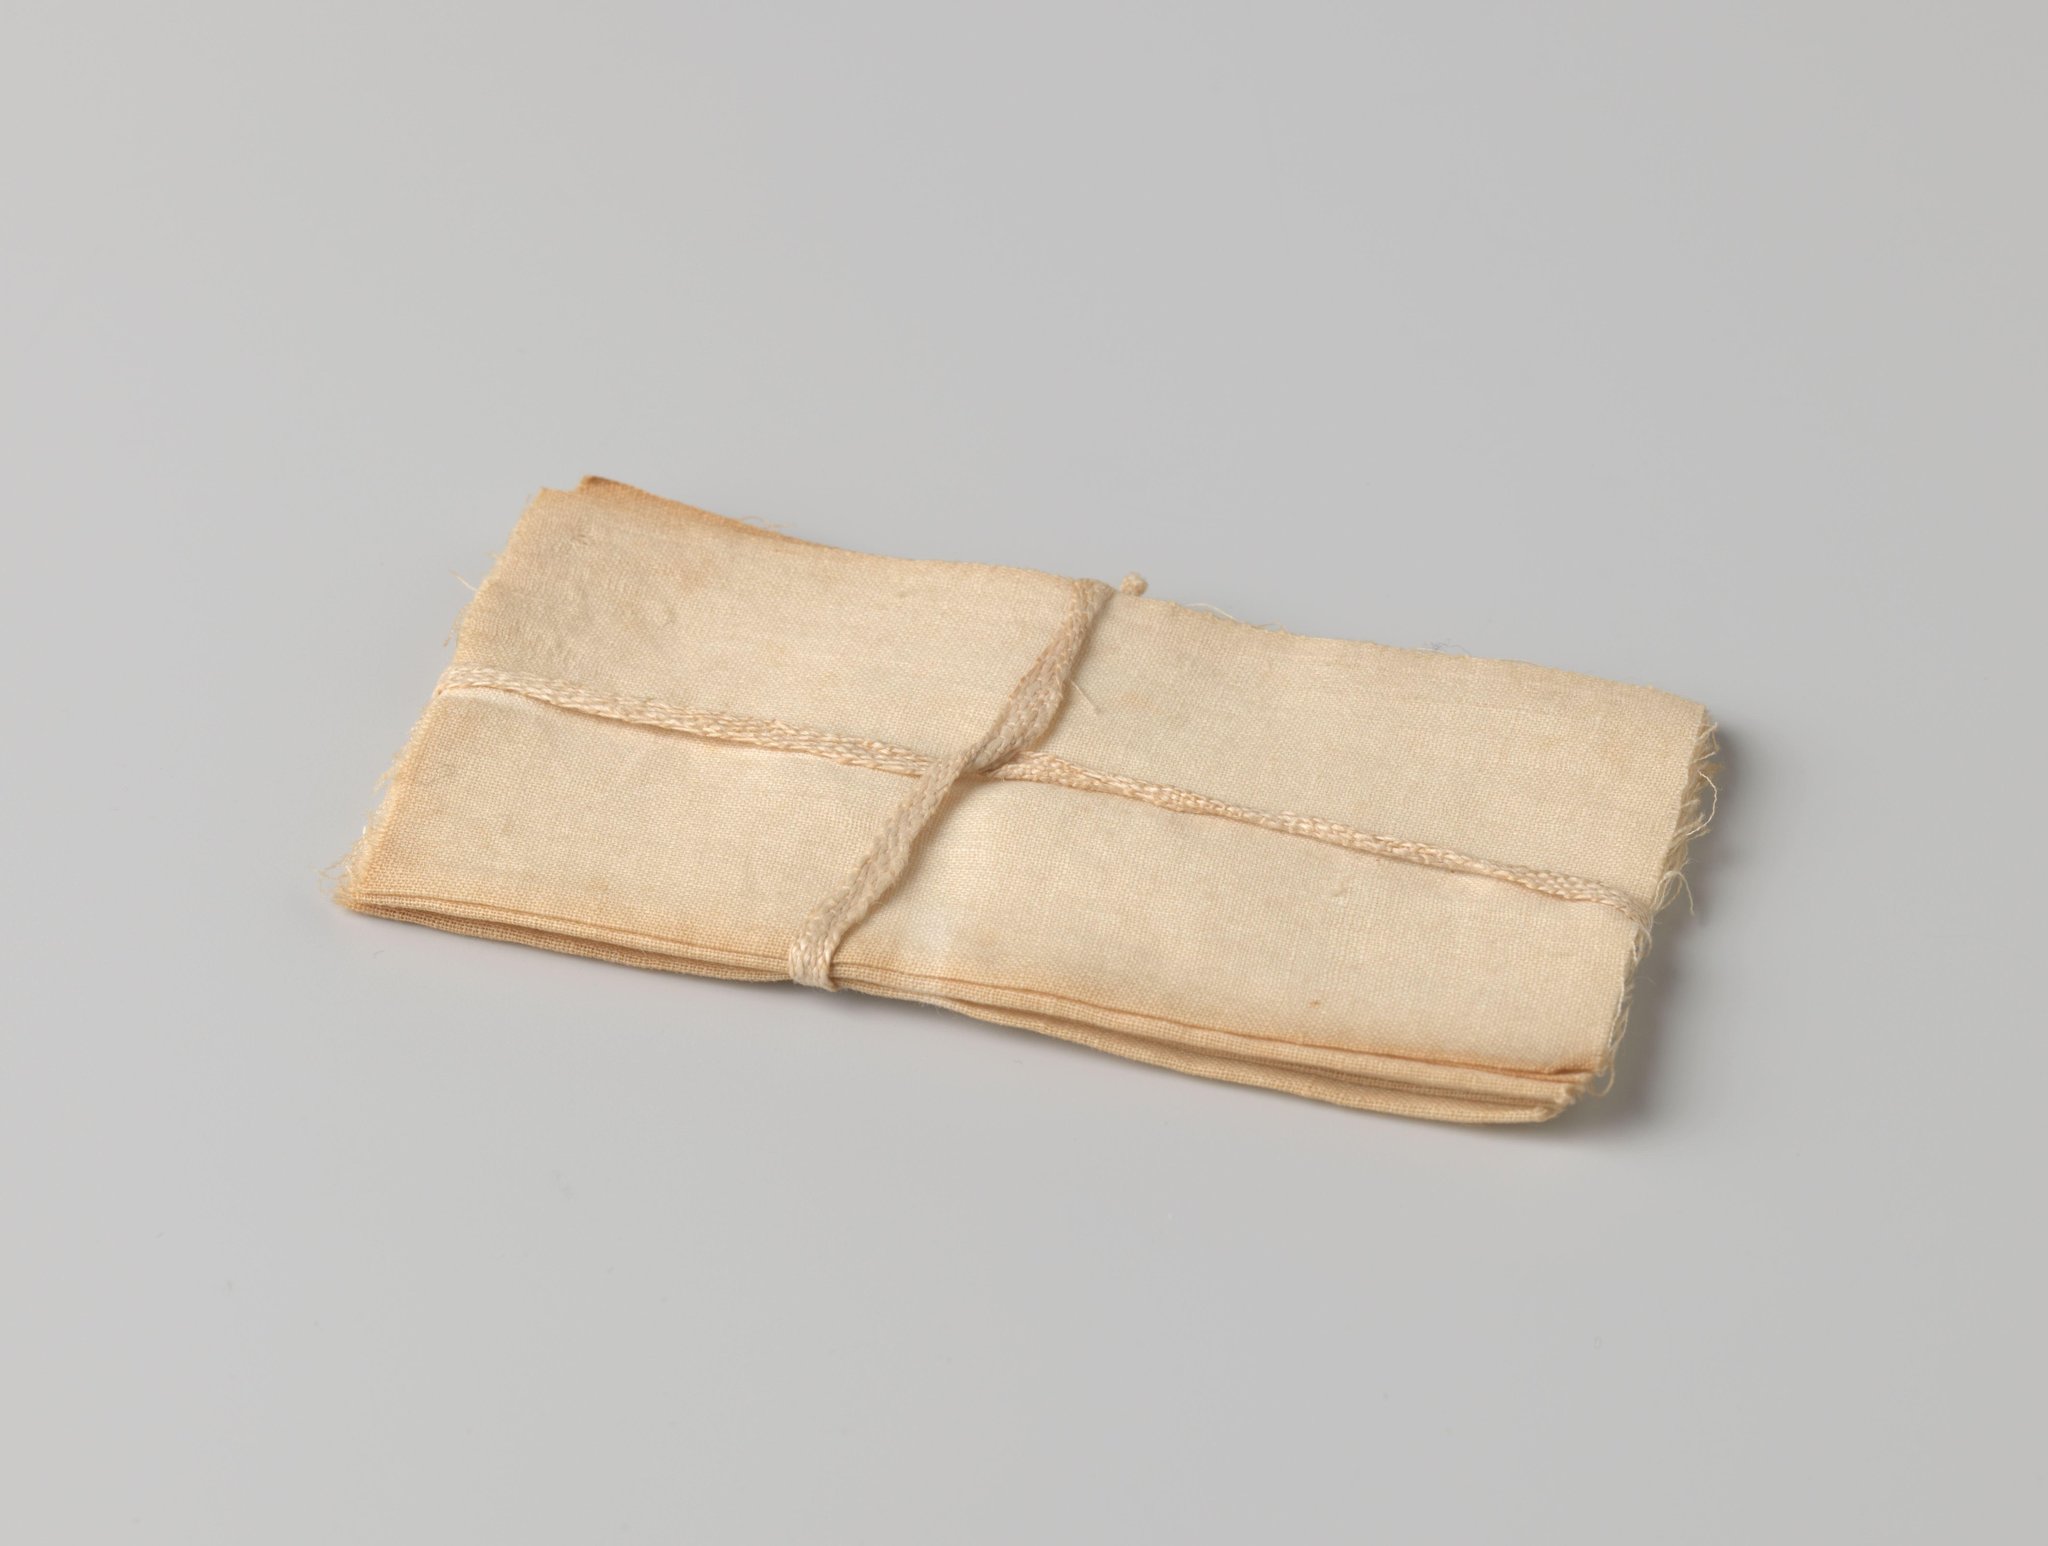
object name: lap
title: Stapel lappen, samengebonden met een band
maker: Anonymous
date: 1750-1800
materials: cotton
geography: netherlands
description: Een stapel van zes katoenen lappen, opgevouwen en met linnenband samengebonden.